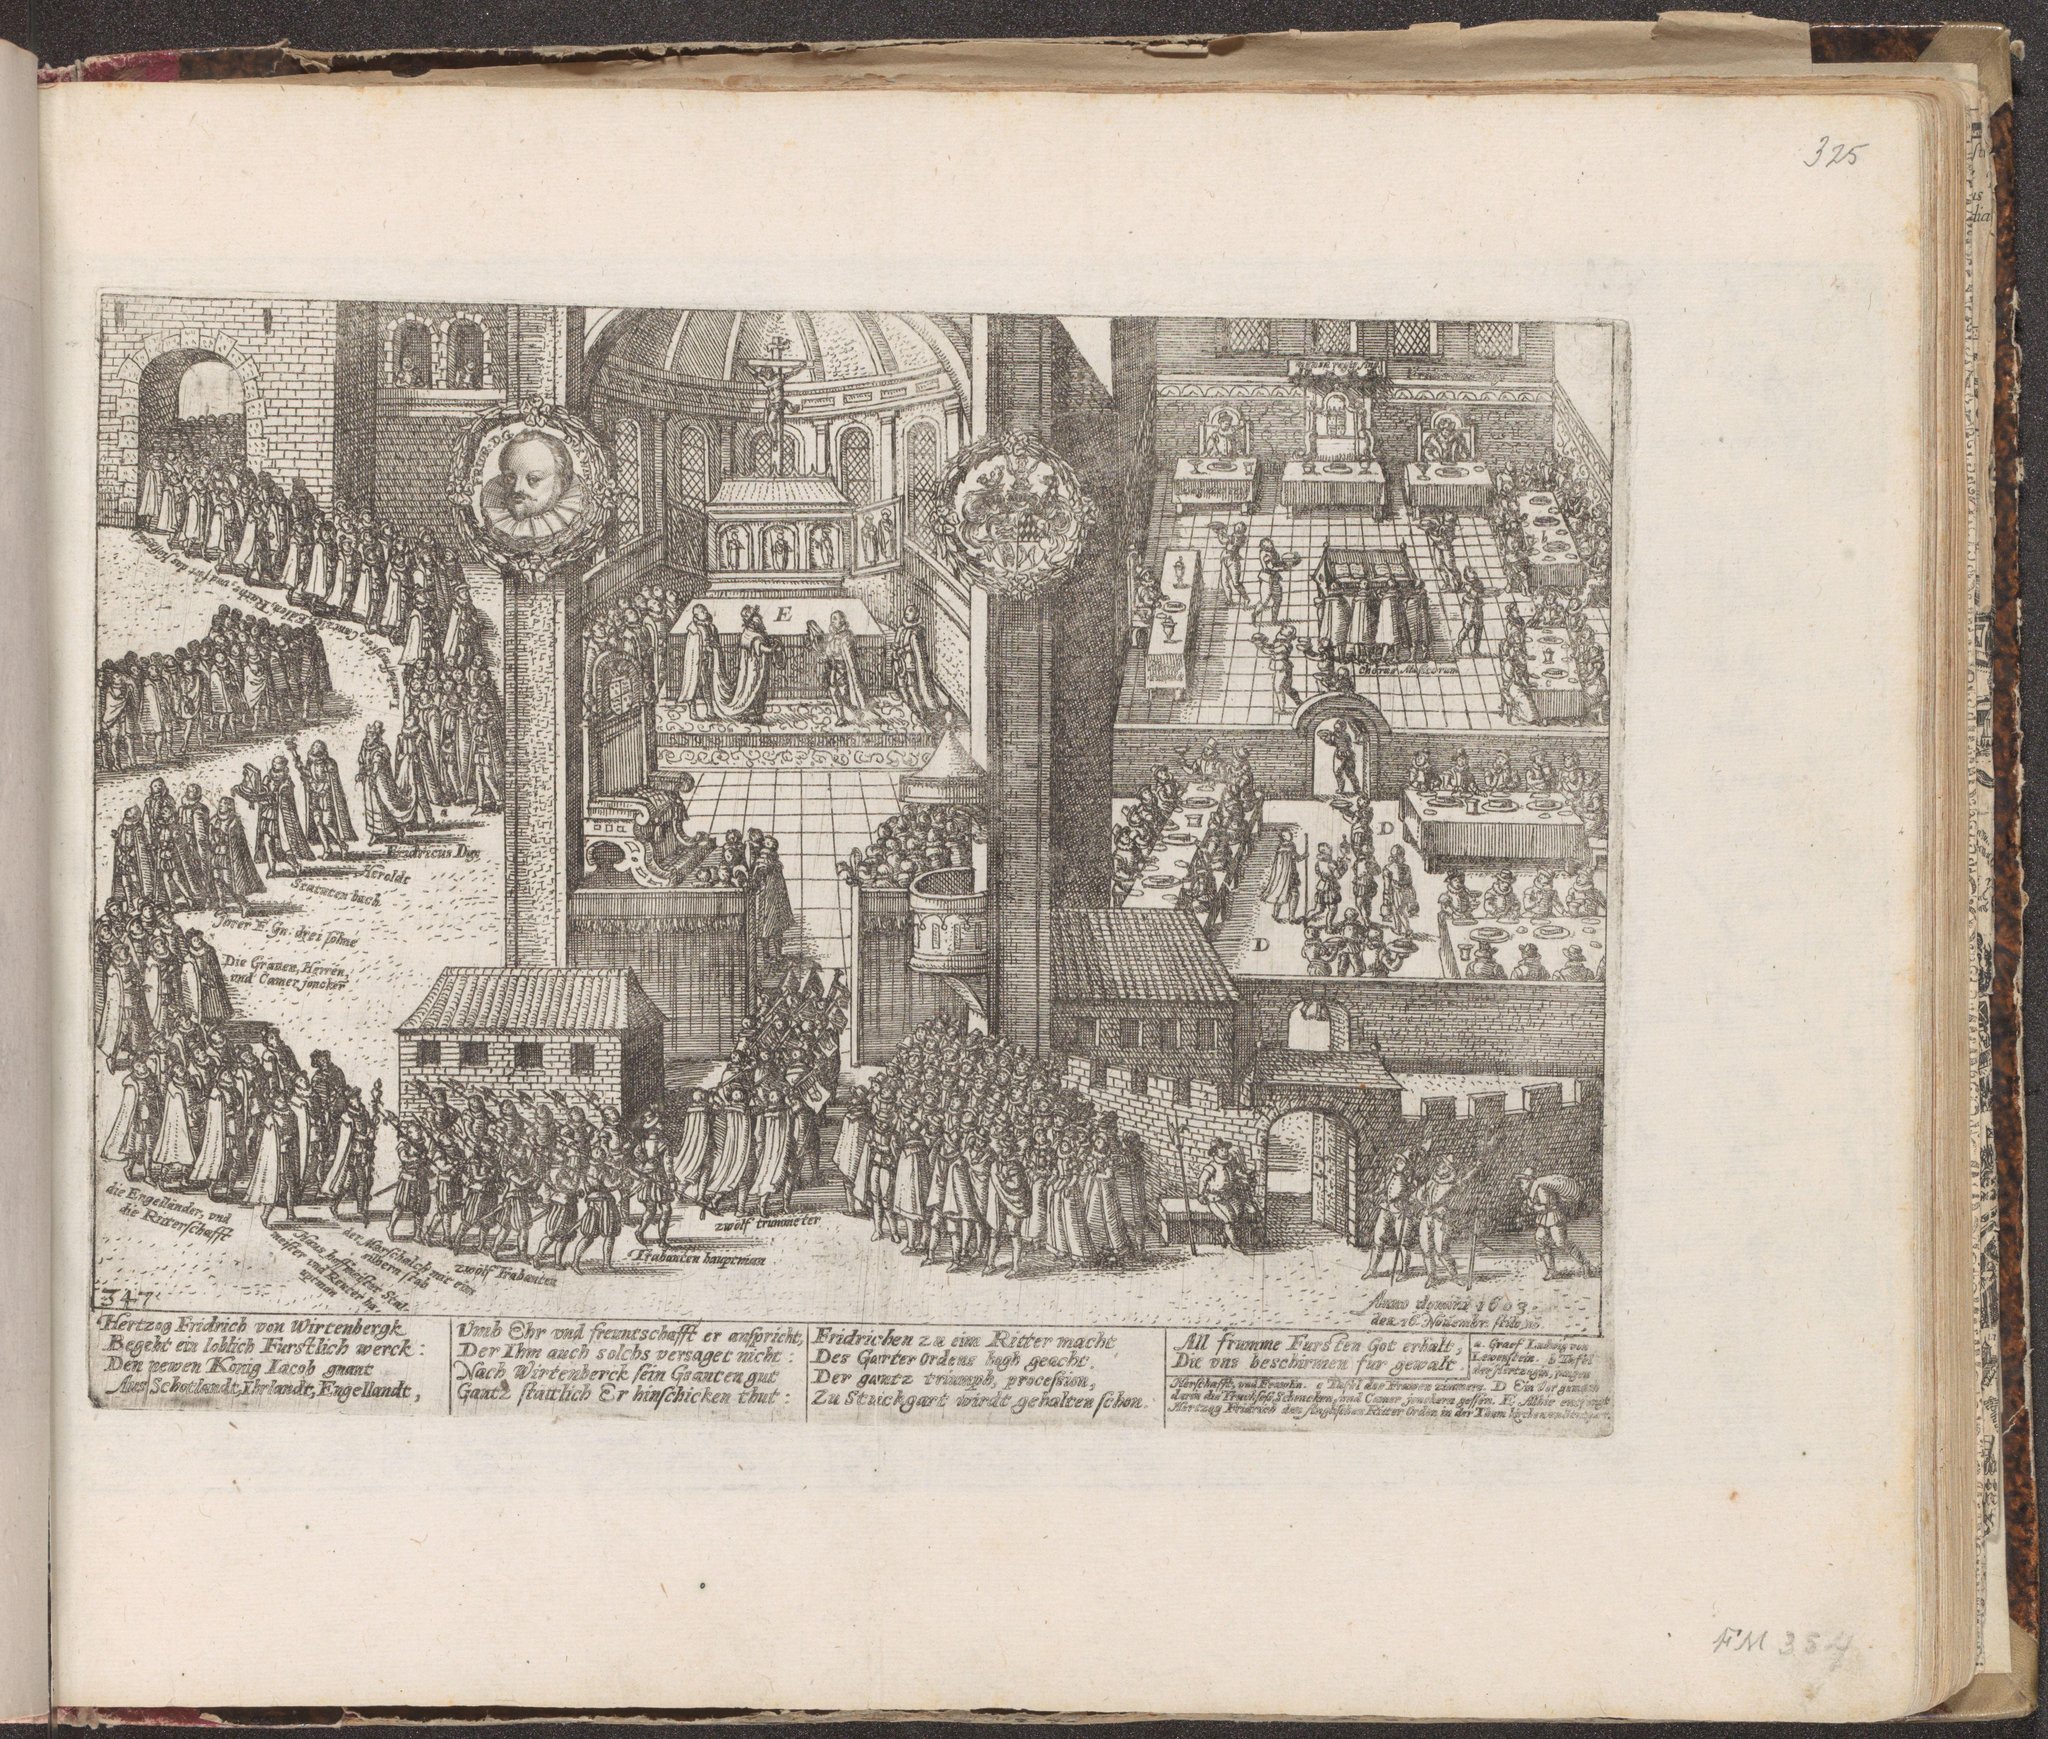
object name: print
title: Serie 4: Franse, Duitse en Engelse Gebeurtenissen, 1576-1610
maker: frans hogenberg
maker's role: print maker, publisher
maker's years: 1538-1590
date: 1603-1605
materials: paper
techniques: etching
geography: cologne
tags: knighthood order, becoming a knight, knighting, london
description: Hertog Frederik van Württemberg door Jacobus I tot Ridder in de Orde van de Kousenband geslagen, 16 november 1603. In de voorstelling opschriften in het Duits. Met onderschrift van 14 regels en legenda A-E in het Duits. Linksonder genummerd: 347. De prent maakt deel uit van een album.